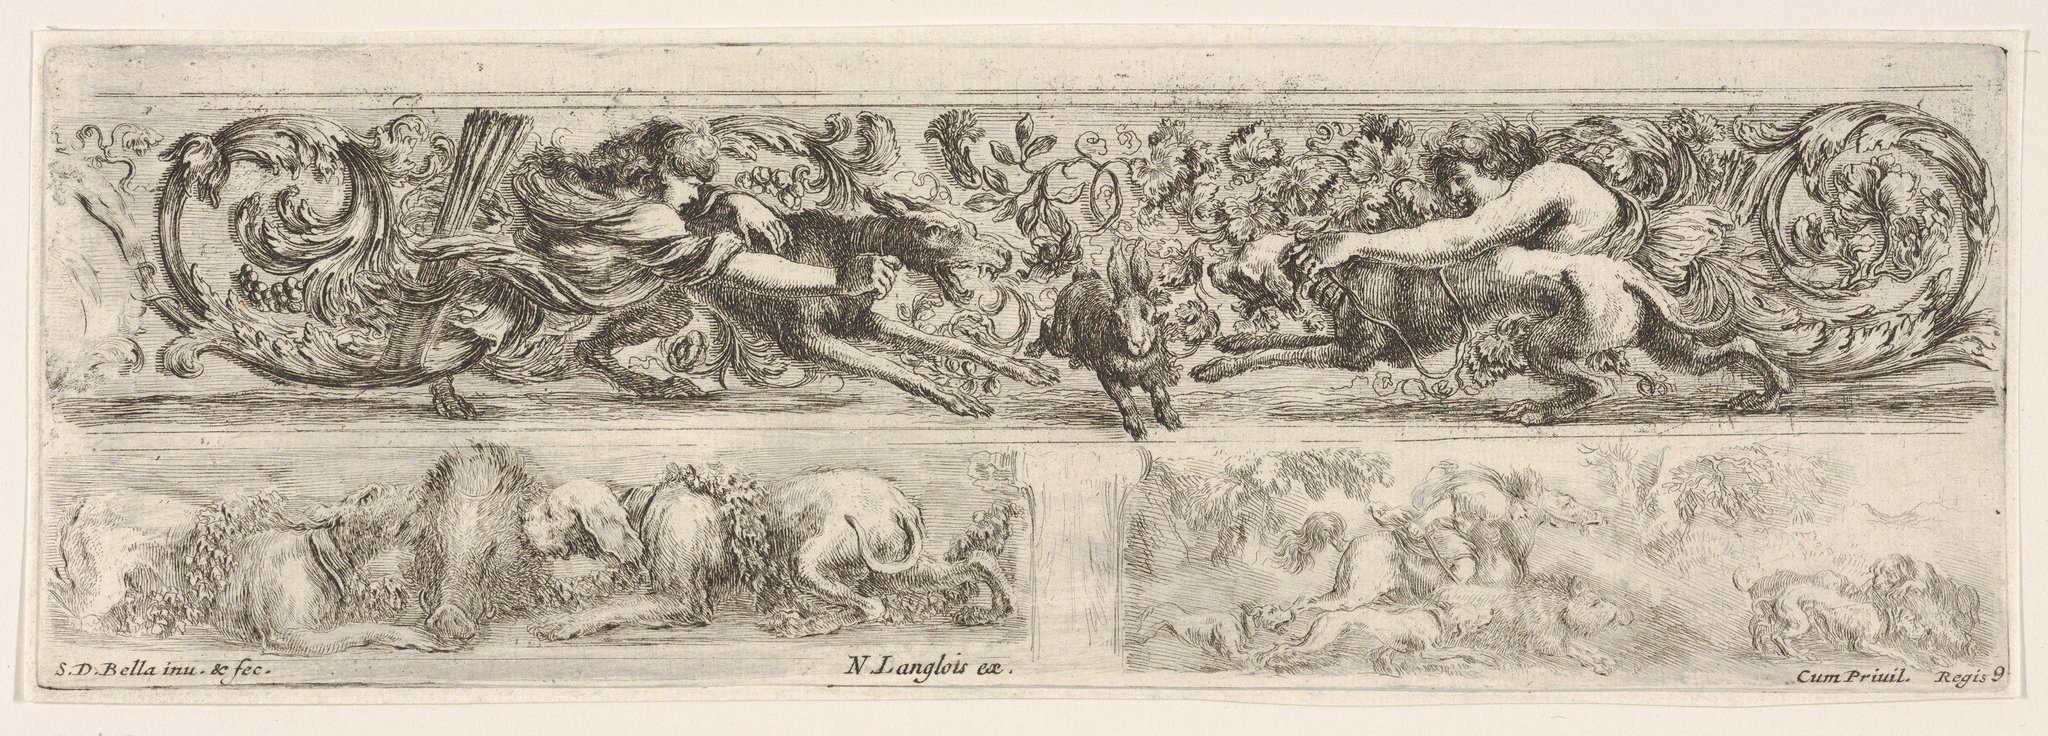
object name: print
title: Designs for Three Friezes with Hunting Themes, plate 9 from "Decorative friezes and foliage" (Ornamenti di fregi e fogliami)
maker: stefano della bella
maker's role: artist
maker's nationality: italian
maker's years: 1610-1664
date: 1645-1650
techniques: etching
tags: dogs,rabbits